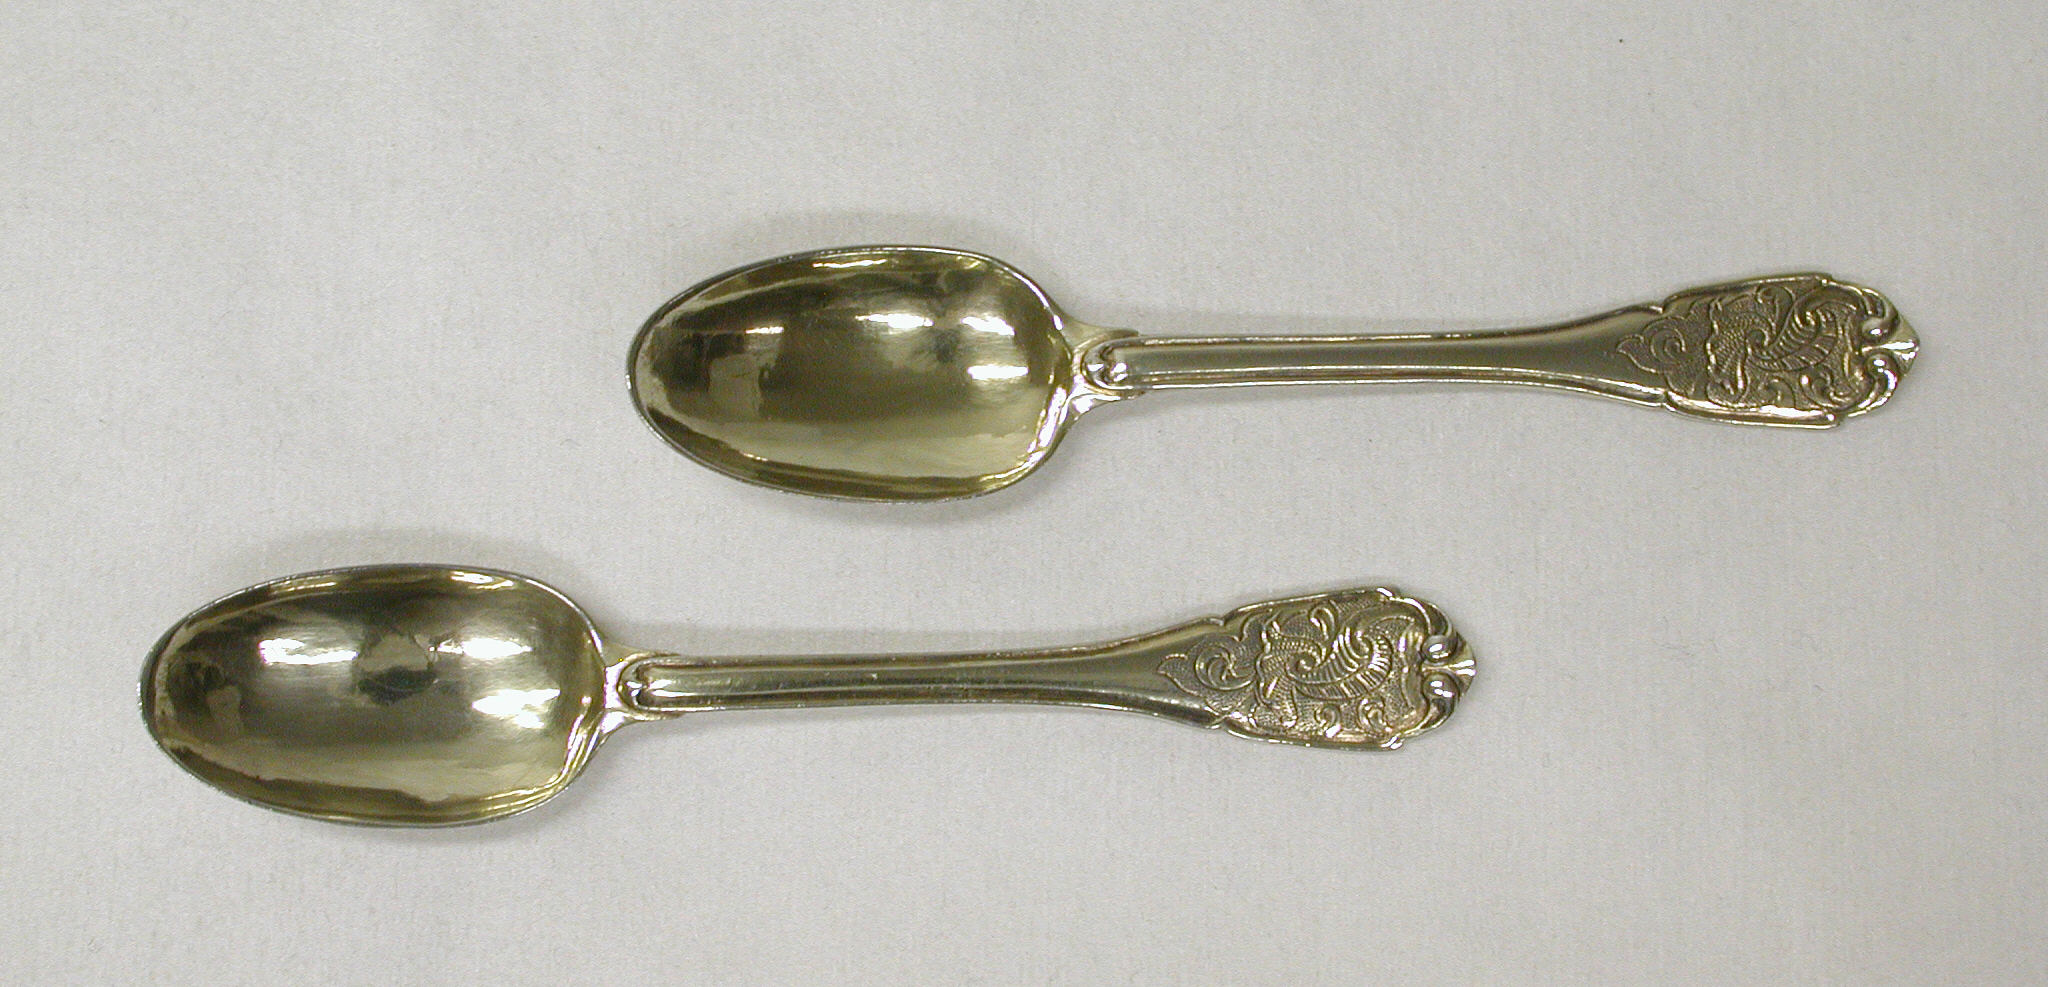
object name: coffee spoon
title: Coffee spoon (one of a pair)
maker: abraham warnberger iii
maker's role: maker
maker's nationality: german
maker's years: 1670-1753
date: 1743-1745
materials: silver gilt